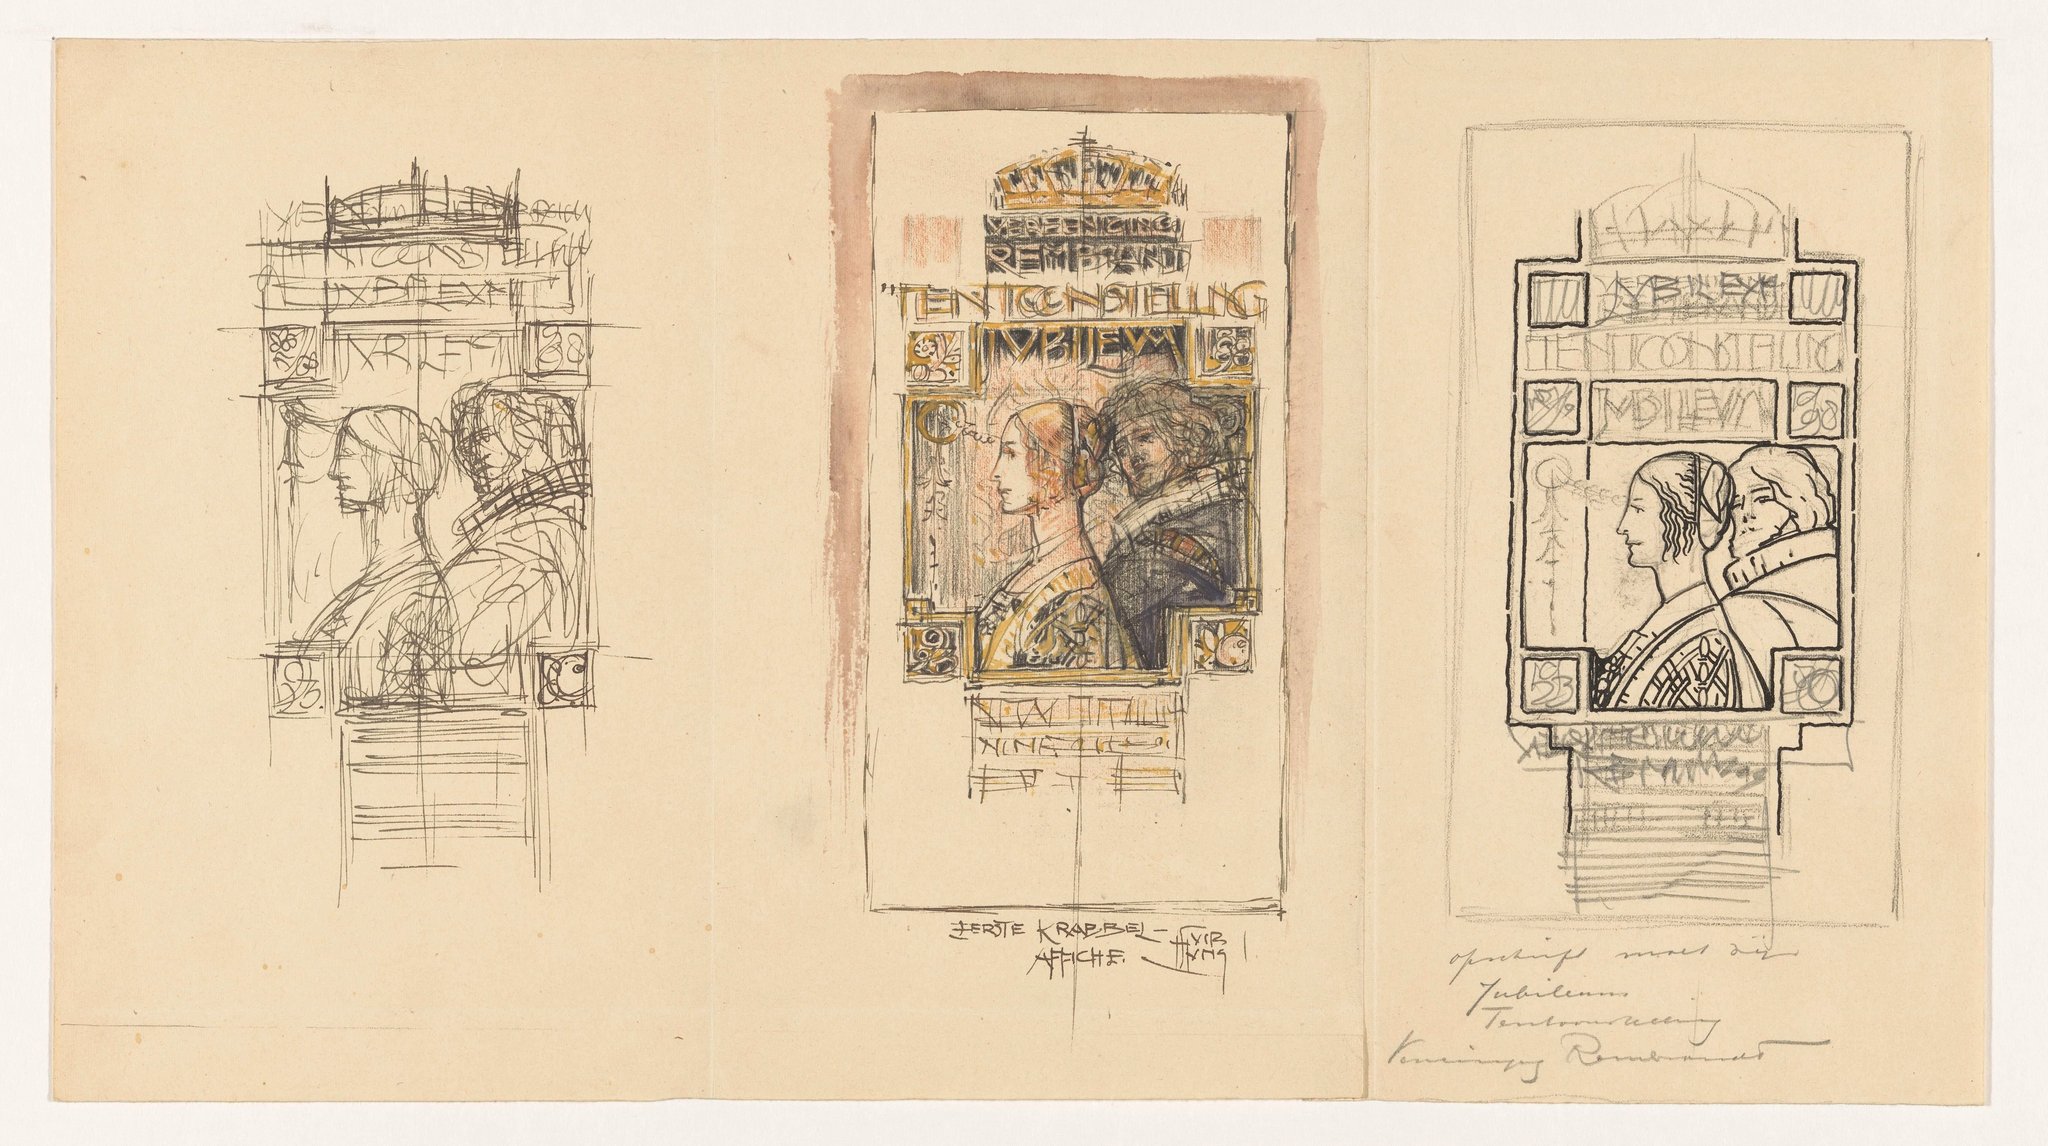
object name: design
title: Drie ontwerpen voor affiches voor de tentoonstelling van Vereniging Rembrandt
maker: huib luns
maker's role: draughtsman, print maker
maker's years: 1881-1942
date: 1920-1923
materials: chalk, ink, paper, pencil, watercolor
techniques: brush, pen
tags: the hague, wilhelmina of the netherlands, public festivities on the occasion of royal events, historical persons, names of organizations, companies, trade unions, etc., poster, temporary exhibition, 'salon', historical events and situations, netherlands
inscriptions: collector's mark: Lugt 2228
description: Drie ontwerpen voor affiches voor de tentoonstelling van Vereniging Rembrandt ter gelegenheid van het regeringsjubileum van Wilhelmina, koningin der Nederlanden in 1923.